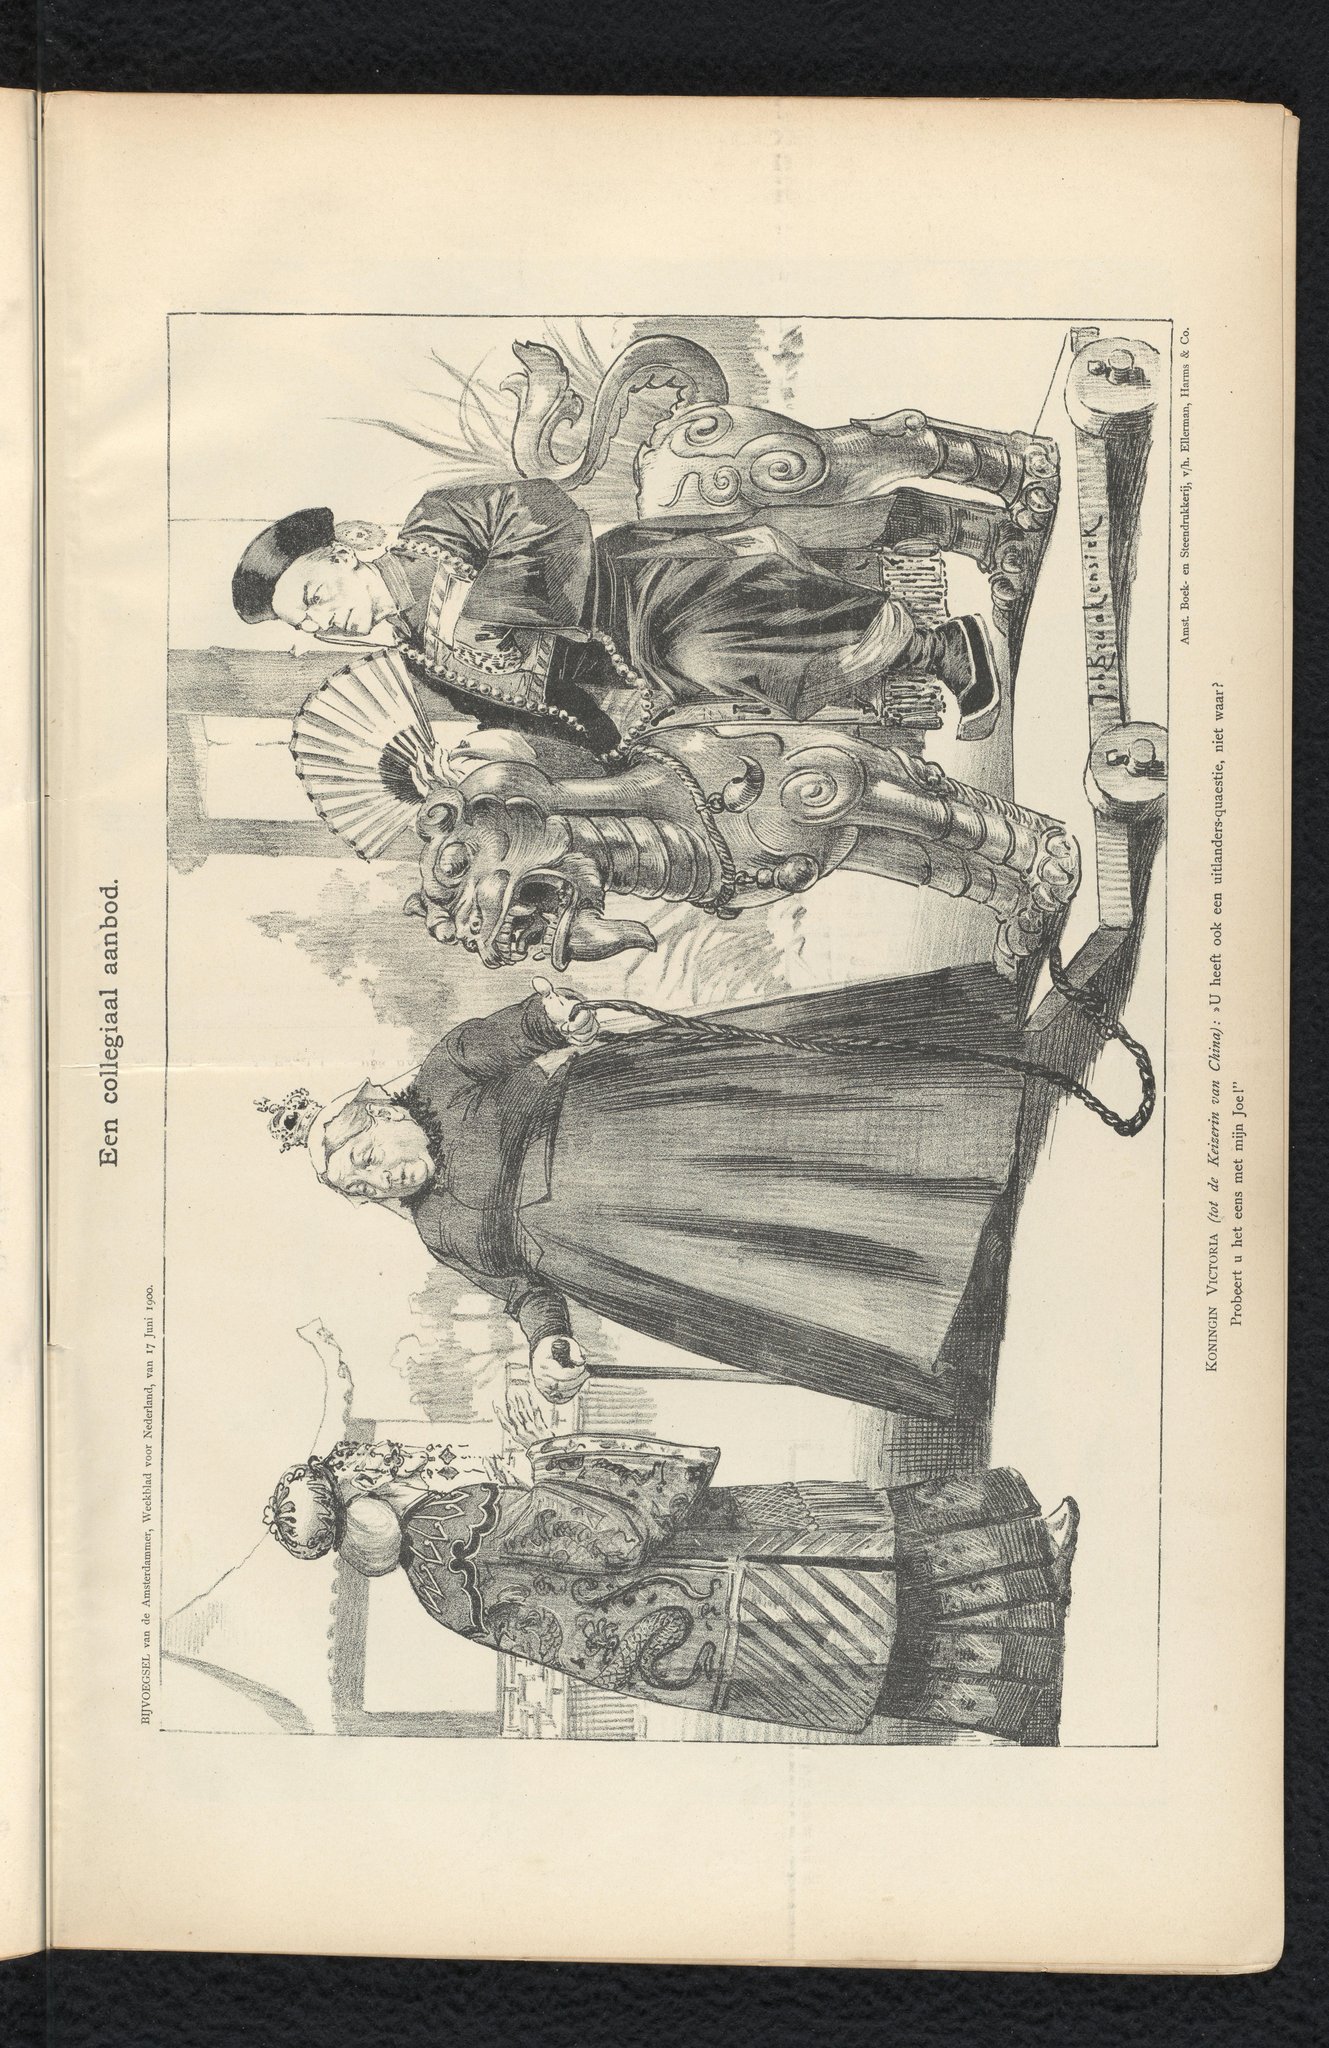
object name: cartoon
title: Een collegiaal aanbod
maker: johan braakensiek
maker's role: draughtsman, print maker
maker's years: 1858-1940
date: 1900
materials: paper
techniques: lithograph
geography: netherlands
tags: victoria (koningin van het verenigd koninkrijk en keizerin van india), cixi (keizerin-regentes van china), fabulous animals ~ snakes (aspic, dragon, hydrus, hydra, amphisbaena, horned snake, cerastes), political caricatures and satires, china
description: Koningin Victoria bij de keizerin van China biedt aan als hulpmiddel tegen 'uitlanders' Joseph Chamberlain, verkleed als Chinees, waaier in de hand, zittend op een speelgoed draak op een karretje.